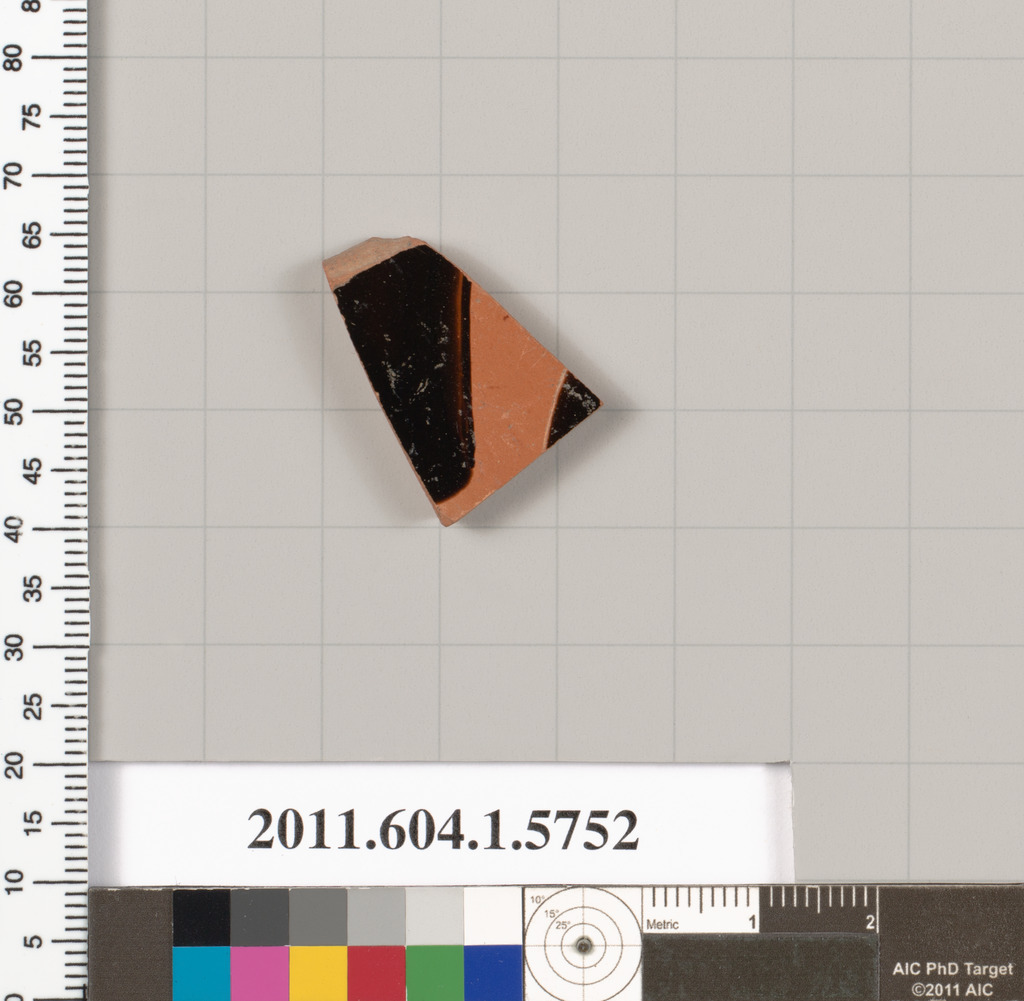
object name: kylix fragment, eye cup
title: Terracotta fragment of a kylix: eye-cup (drinking cup)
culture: greek, attic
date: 525-510 BCE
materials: terracotta